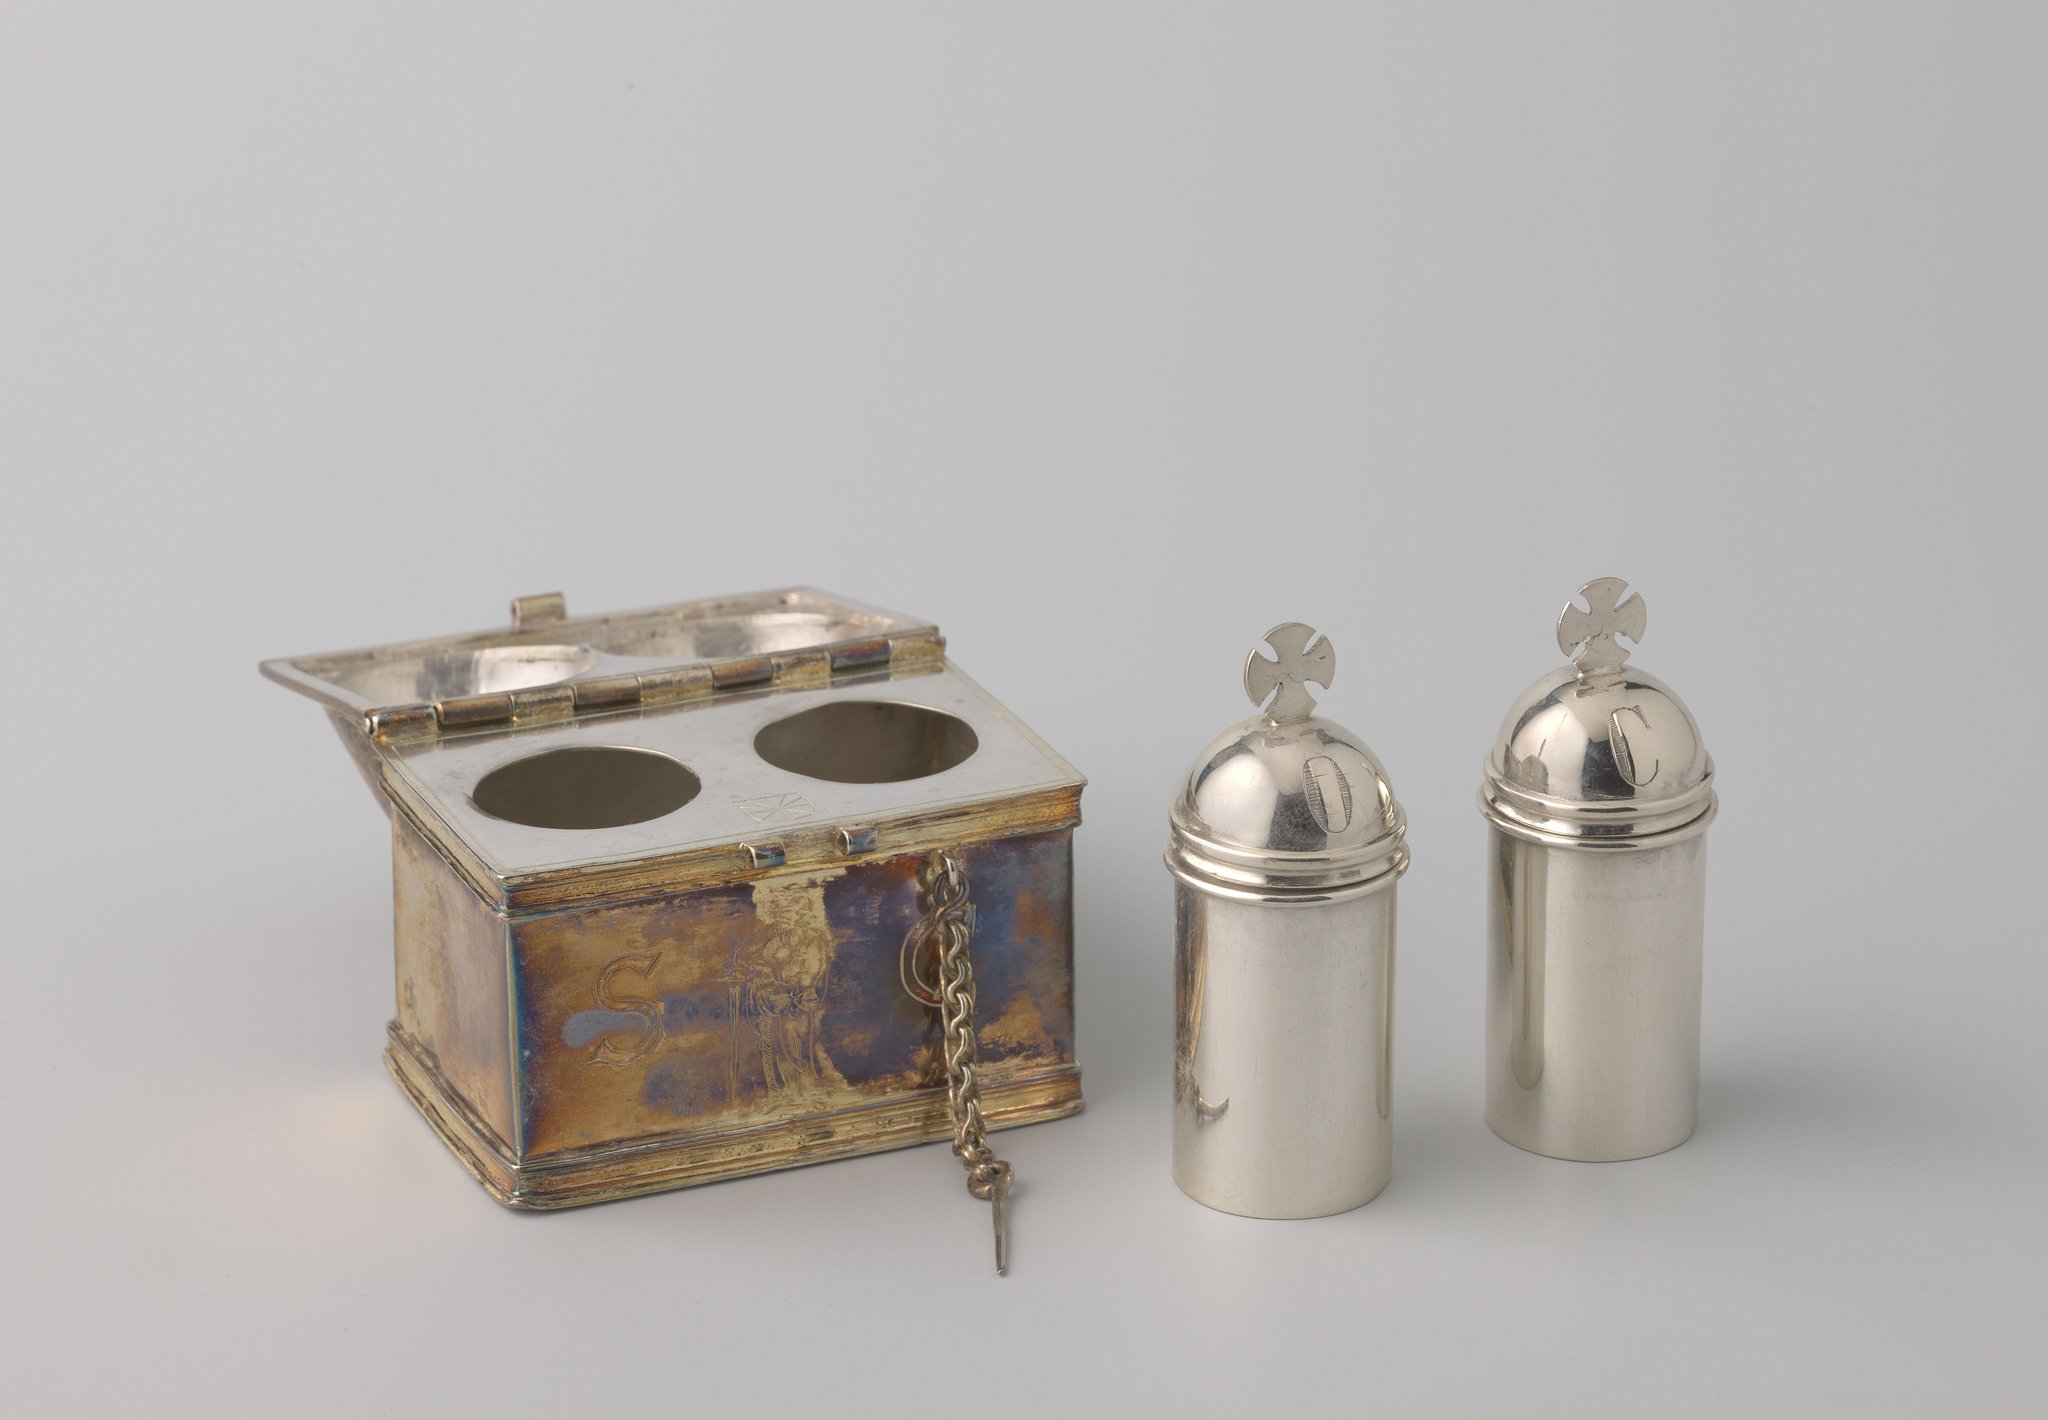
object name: chrismatory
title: Bus, onderdeel van een chrismatorium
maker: Anonymous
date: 1620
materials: silver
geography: brussels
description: Bus van zilver, behorende bij een Chrismatorium. Dient om olie- of zalf in te bewaren.